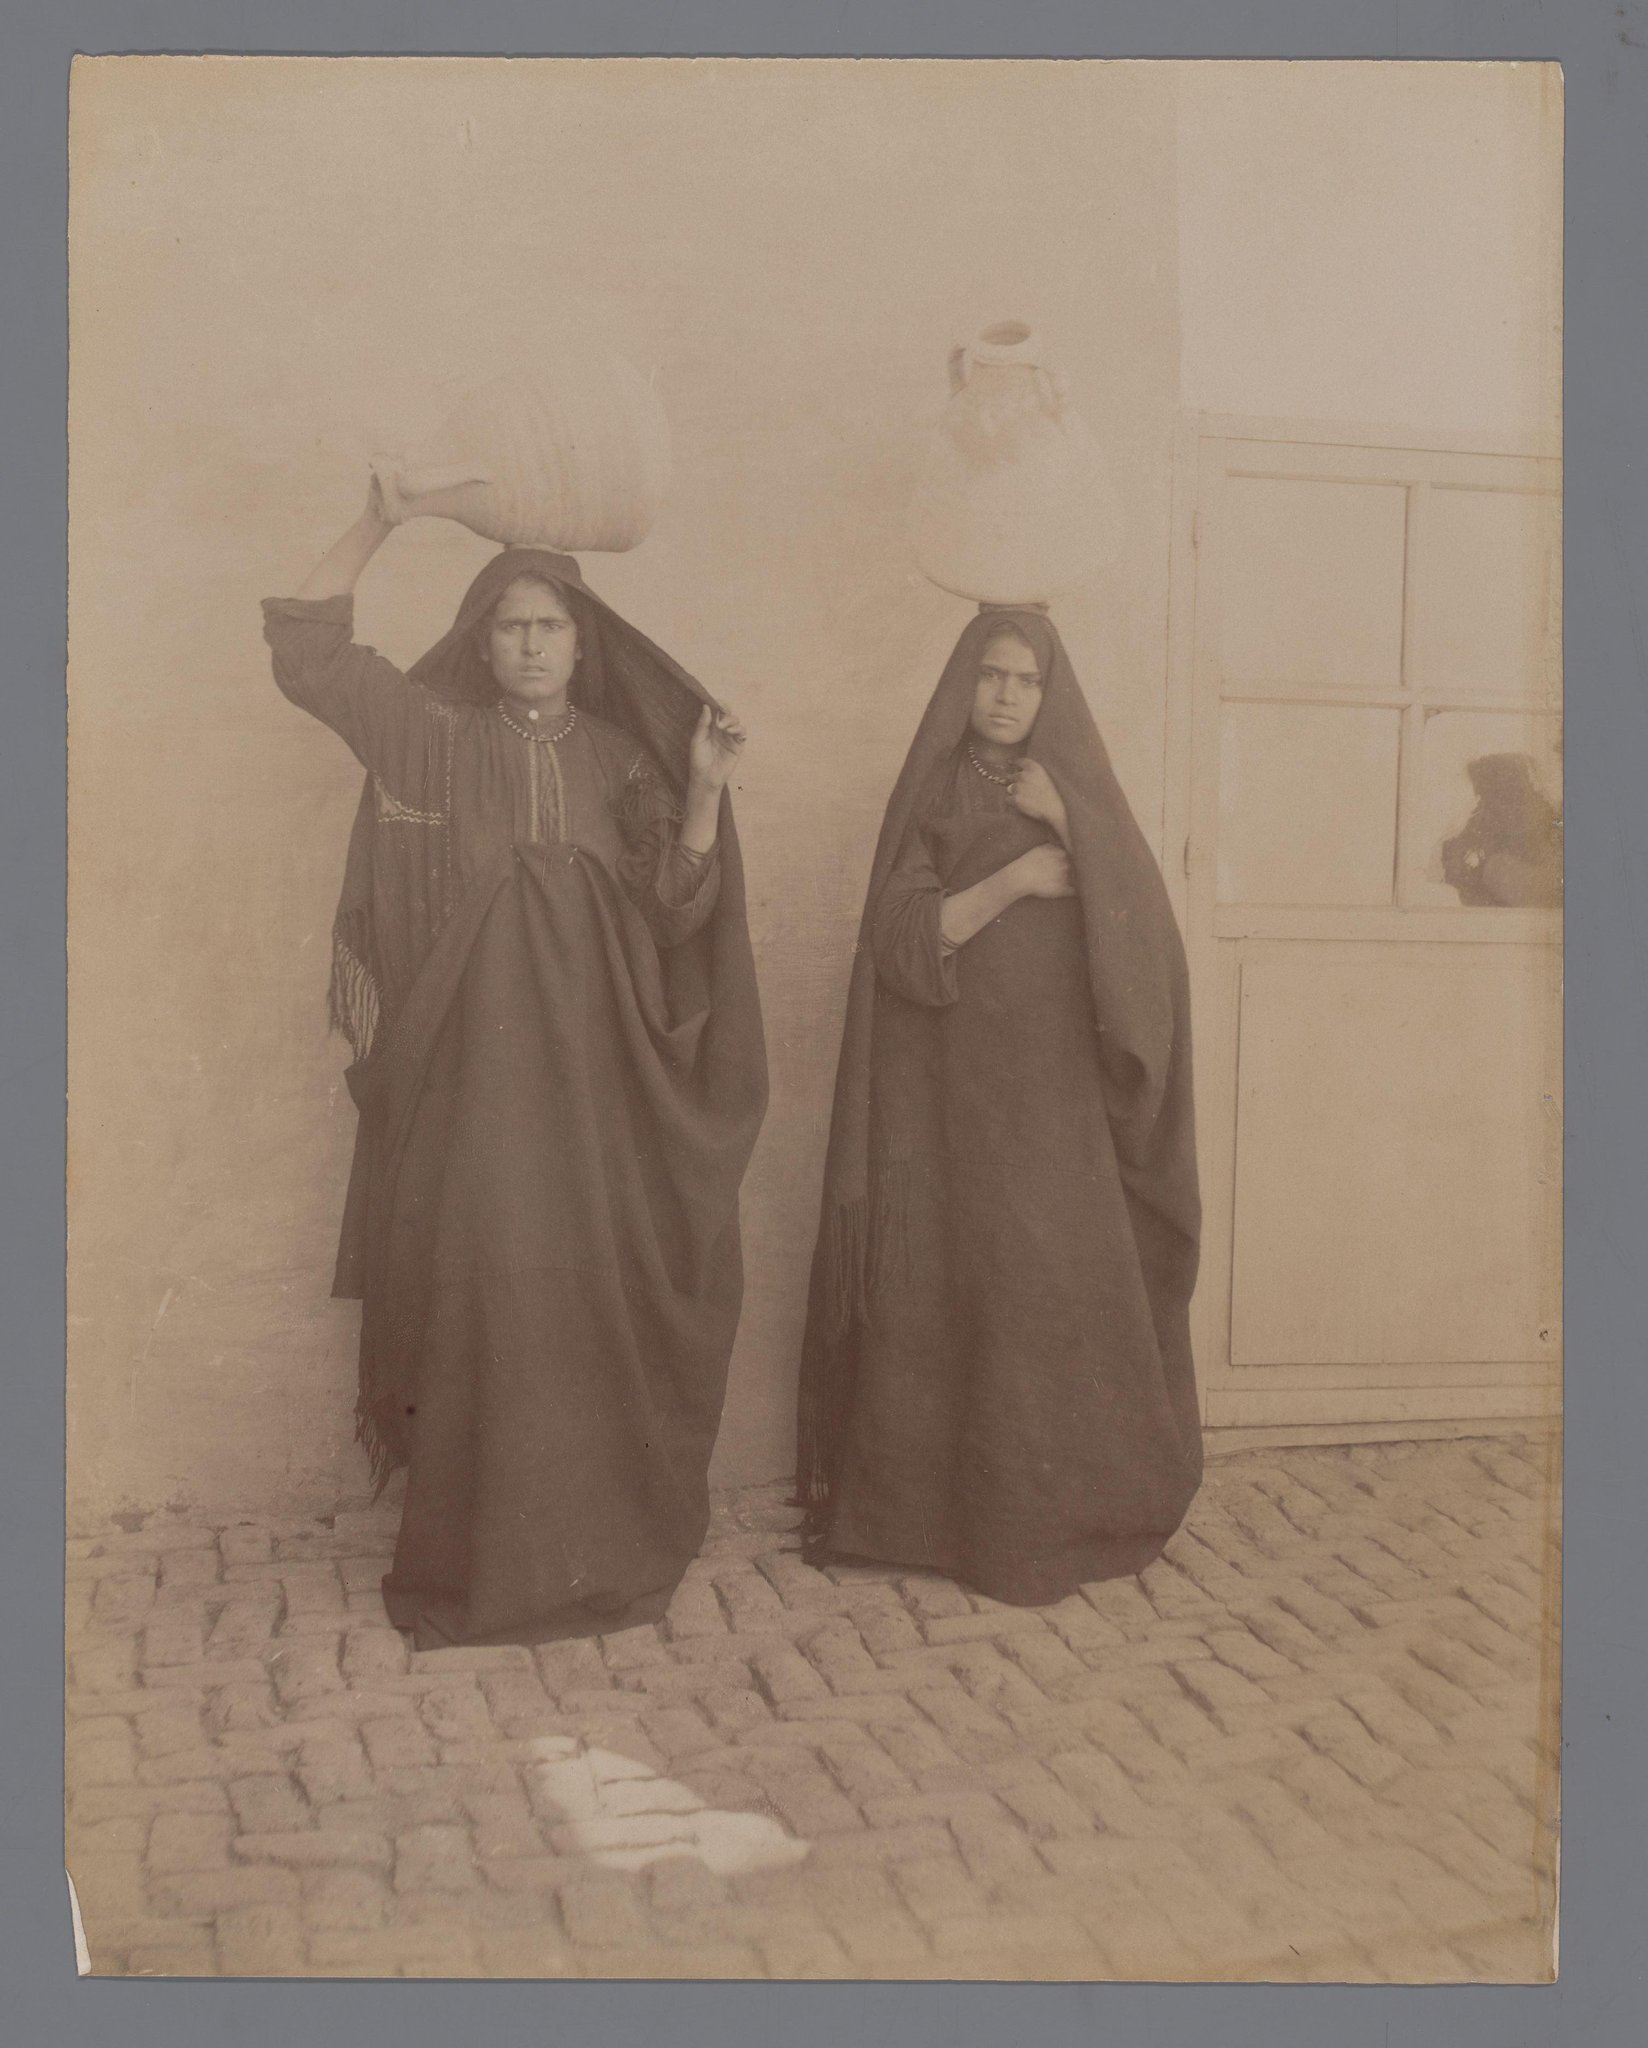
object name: photograph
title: Dubbelportret van twee onbekende Egypische vrouwen met kruiken op hun hoofd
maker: Anonymous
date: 1860-1900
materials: paper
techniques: albumen print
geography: middle east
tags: adult woman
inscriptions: inscription: ‘Dubbel’